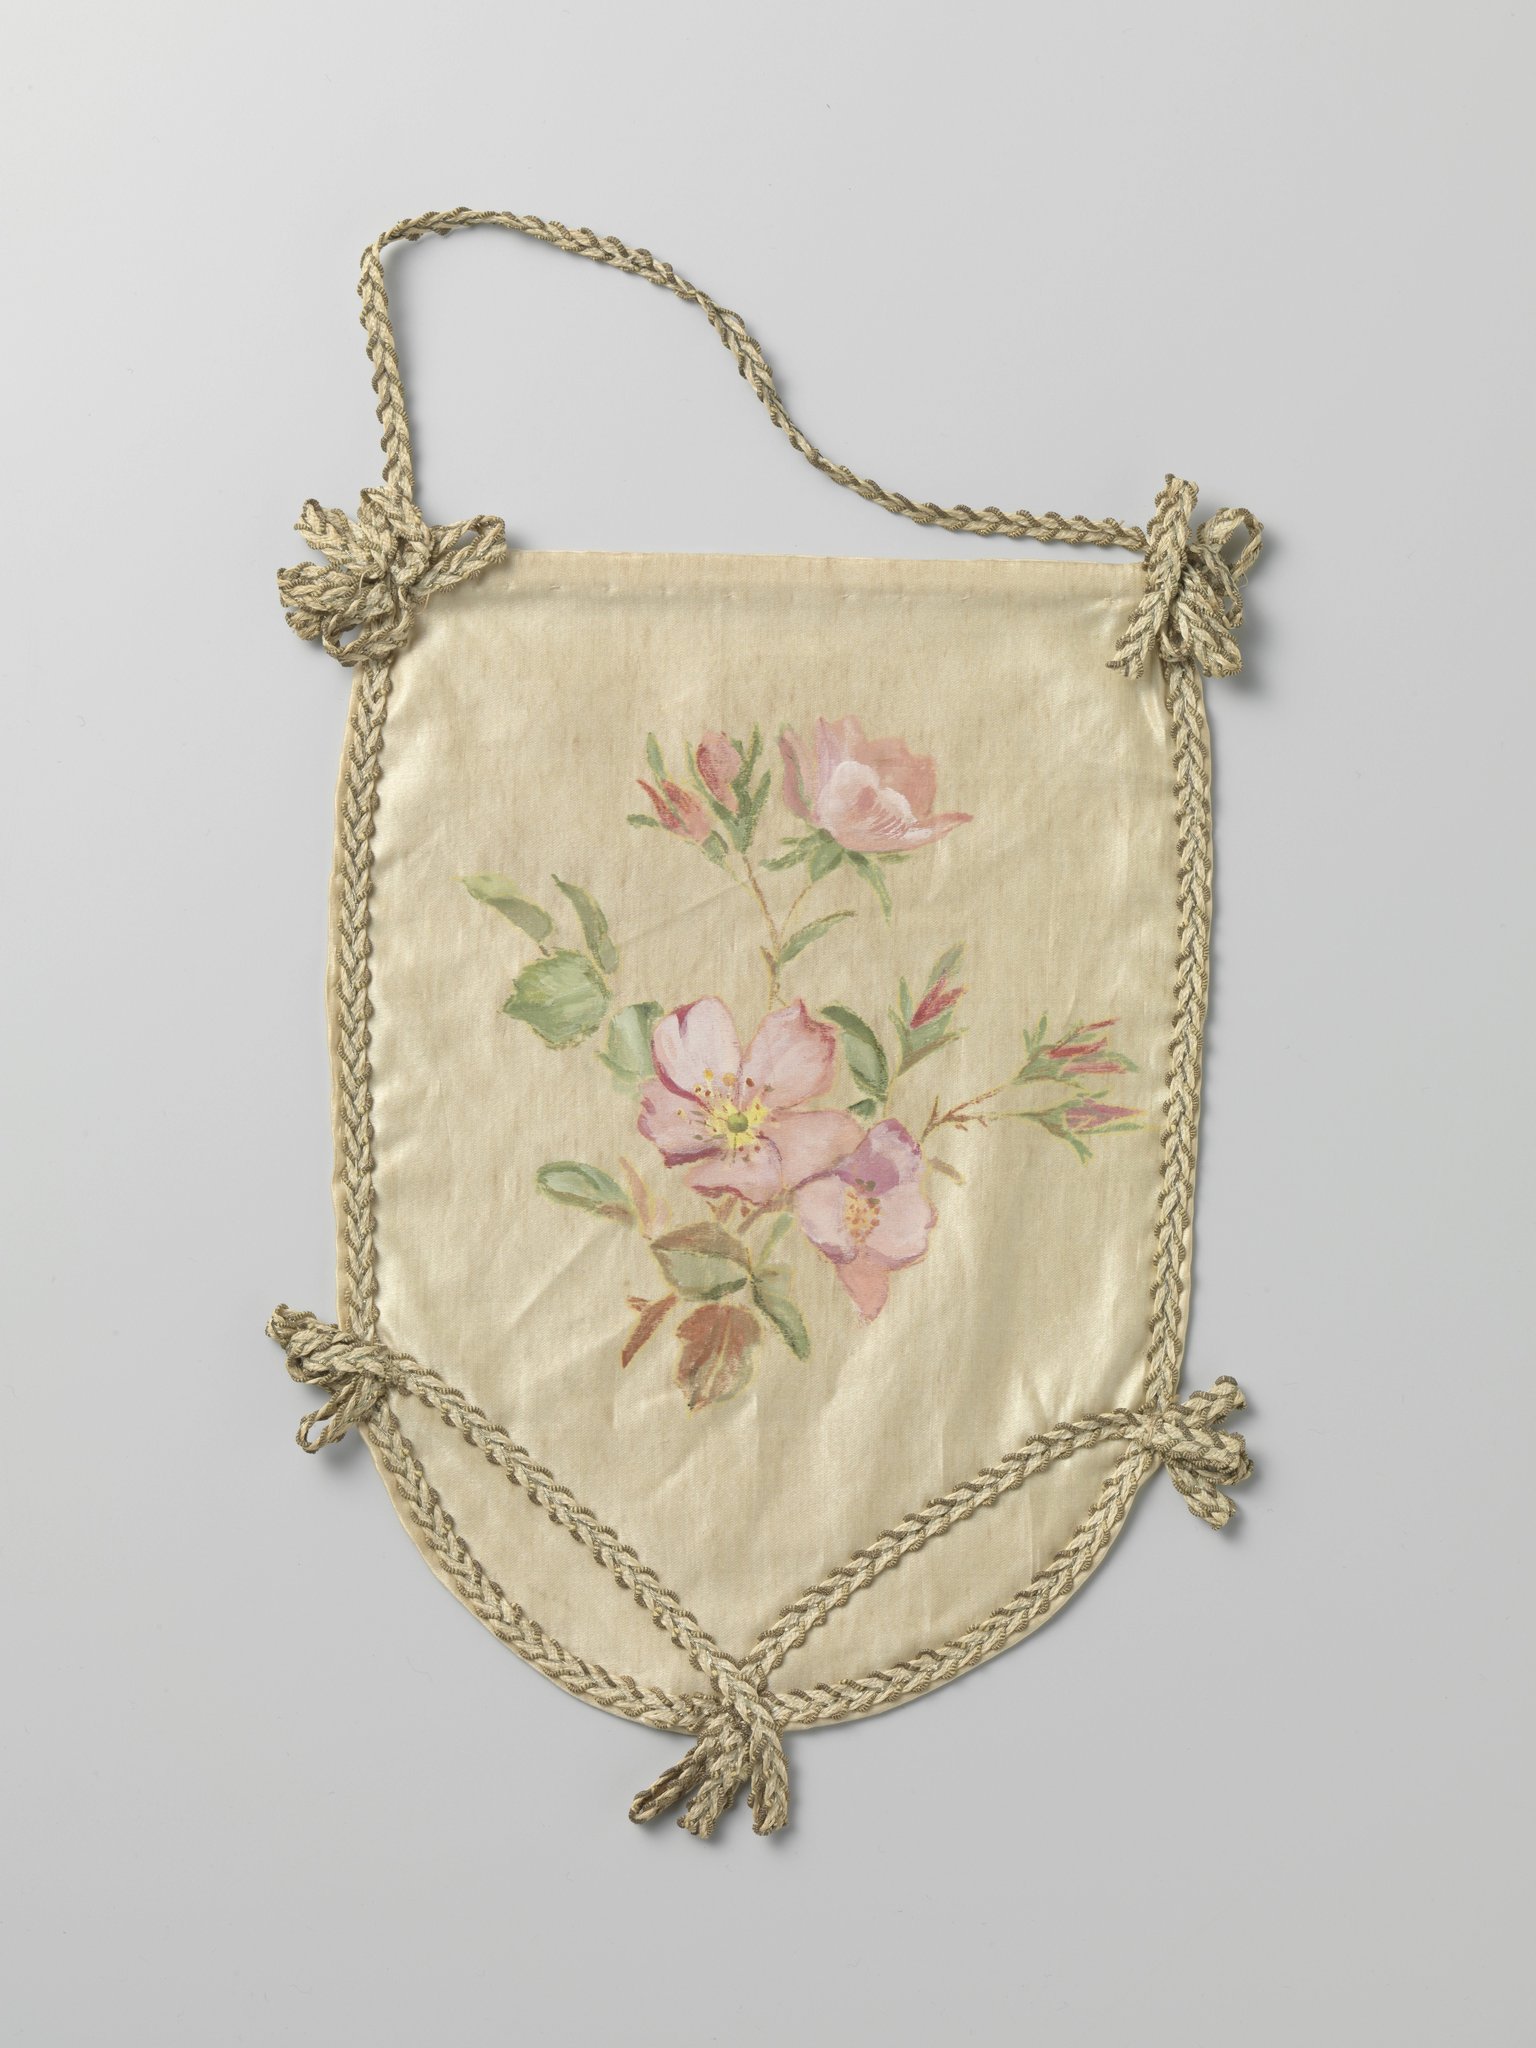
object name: purse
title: Enkel blad van een buidel van ivoorkleurig satijn, waarop in aquarel groene takken en roze bloemen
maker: Anonymous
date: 1880-1890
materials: gold thread, silk, watercolor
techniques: aquarelle, braiding, weave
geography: netherlands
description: Enkel blad van een buidel van ivoorkleurig satijn, waarop in het midden in aquarel groene takken en roze bloemen en knoppen. Het blad is omboord met een gevlochten tresband van witte zijde en gouddraad, met onderaan een band in V-vorm en waar de banden kruisen een strik. De band loopt door in een hengsel aan de bovenkant. In een tunnel langs de bovenste rand is een verstevigde strook.